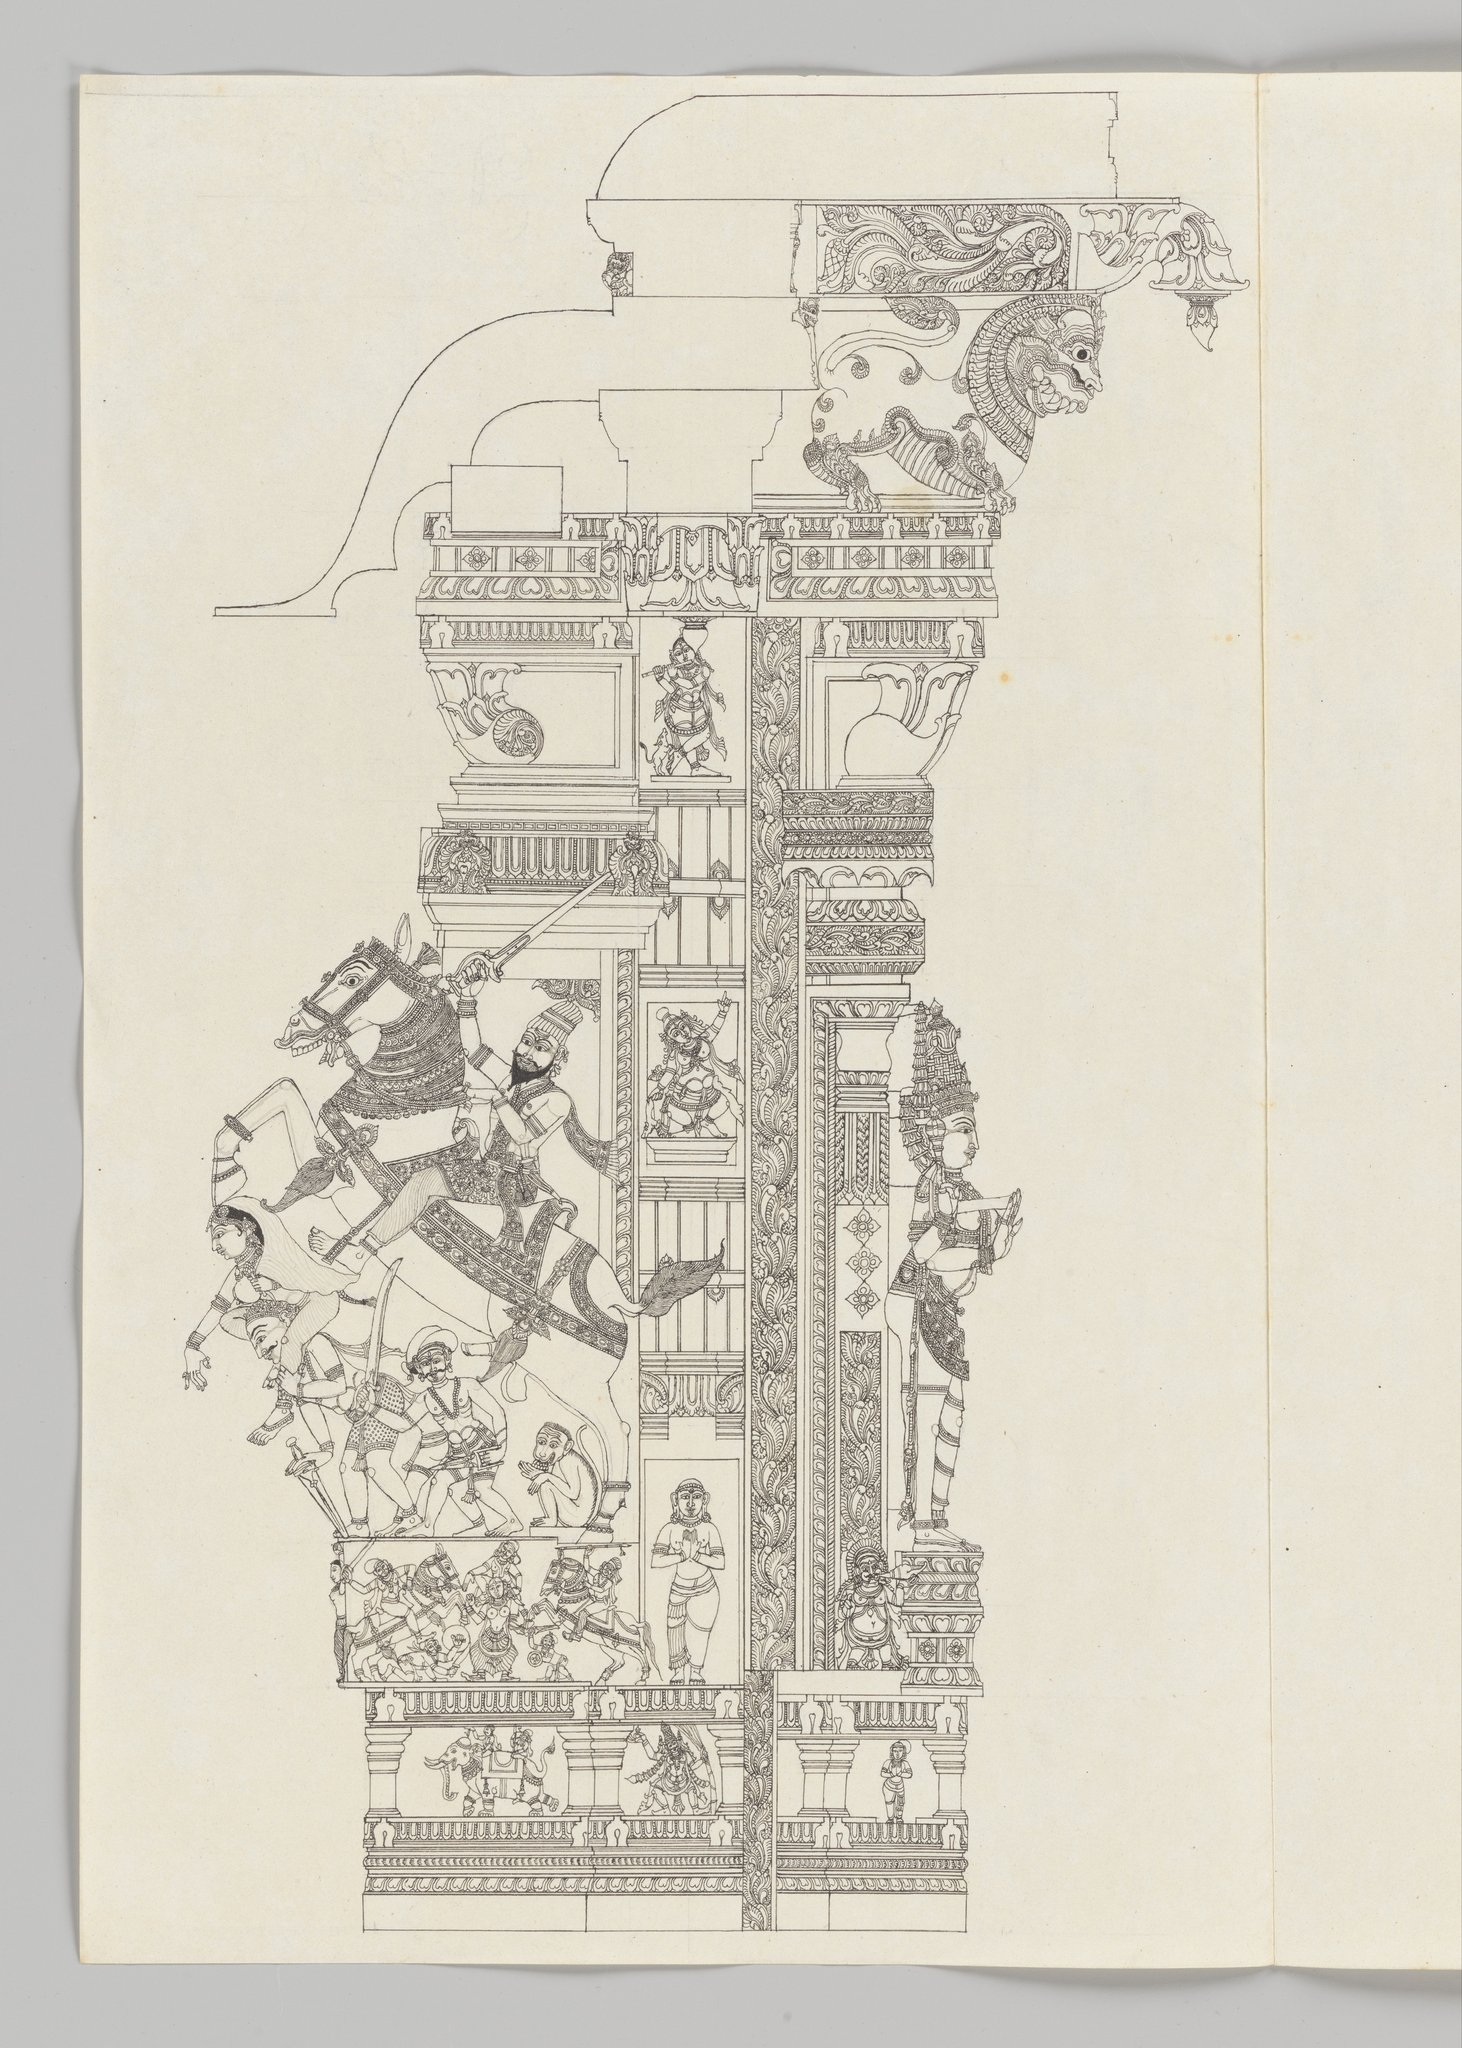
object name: drawing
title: Ardanarishvara; equestrian warrior with raised sword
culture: indian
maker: unidentified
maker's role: artist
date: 1800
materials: ink, paper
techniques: wash